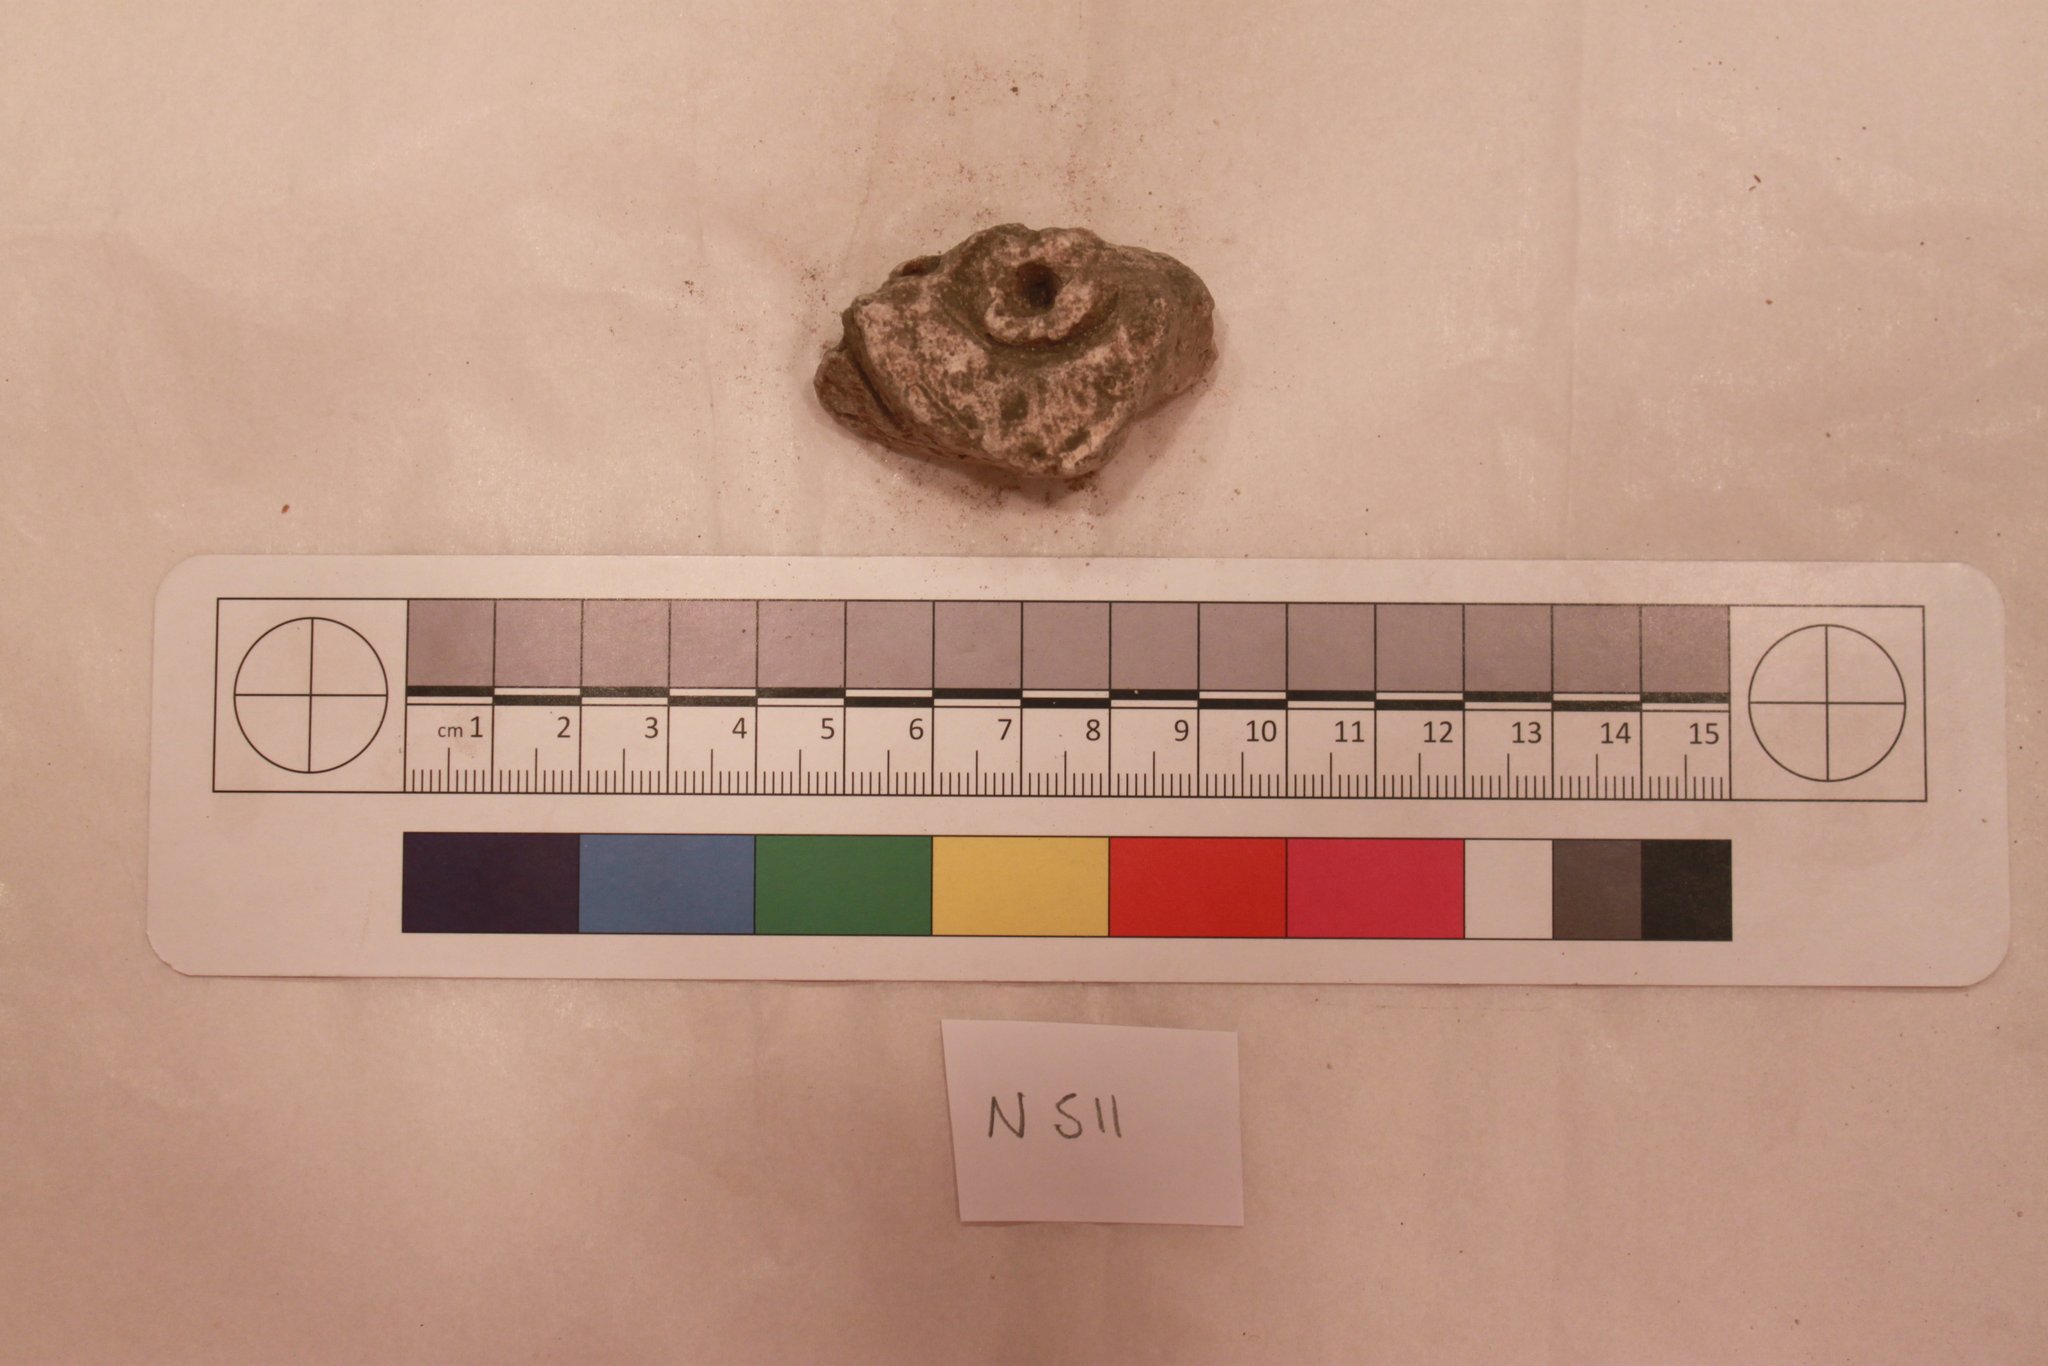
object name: fragment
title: Stucco Fragment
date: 701-1200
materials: plaster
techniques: carving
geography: iran